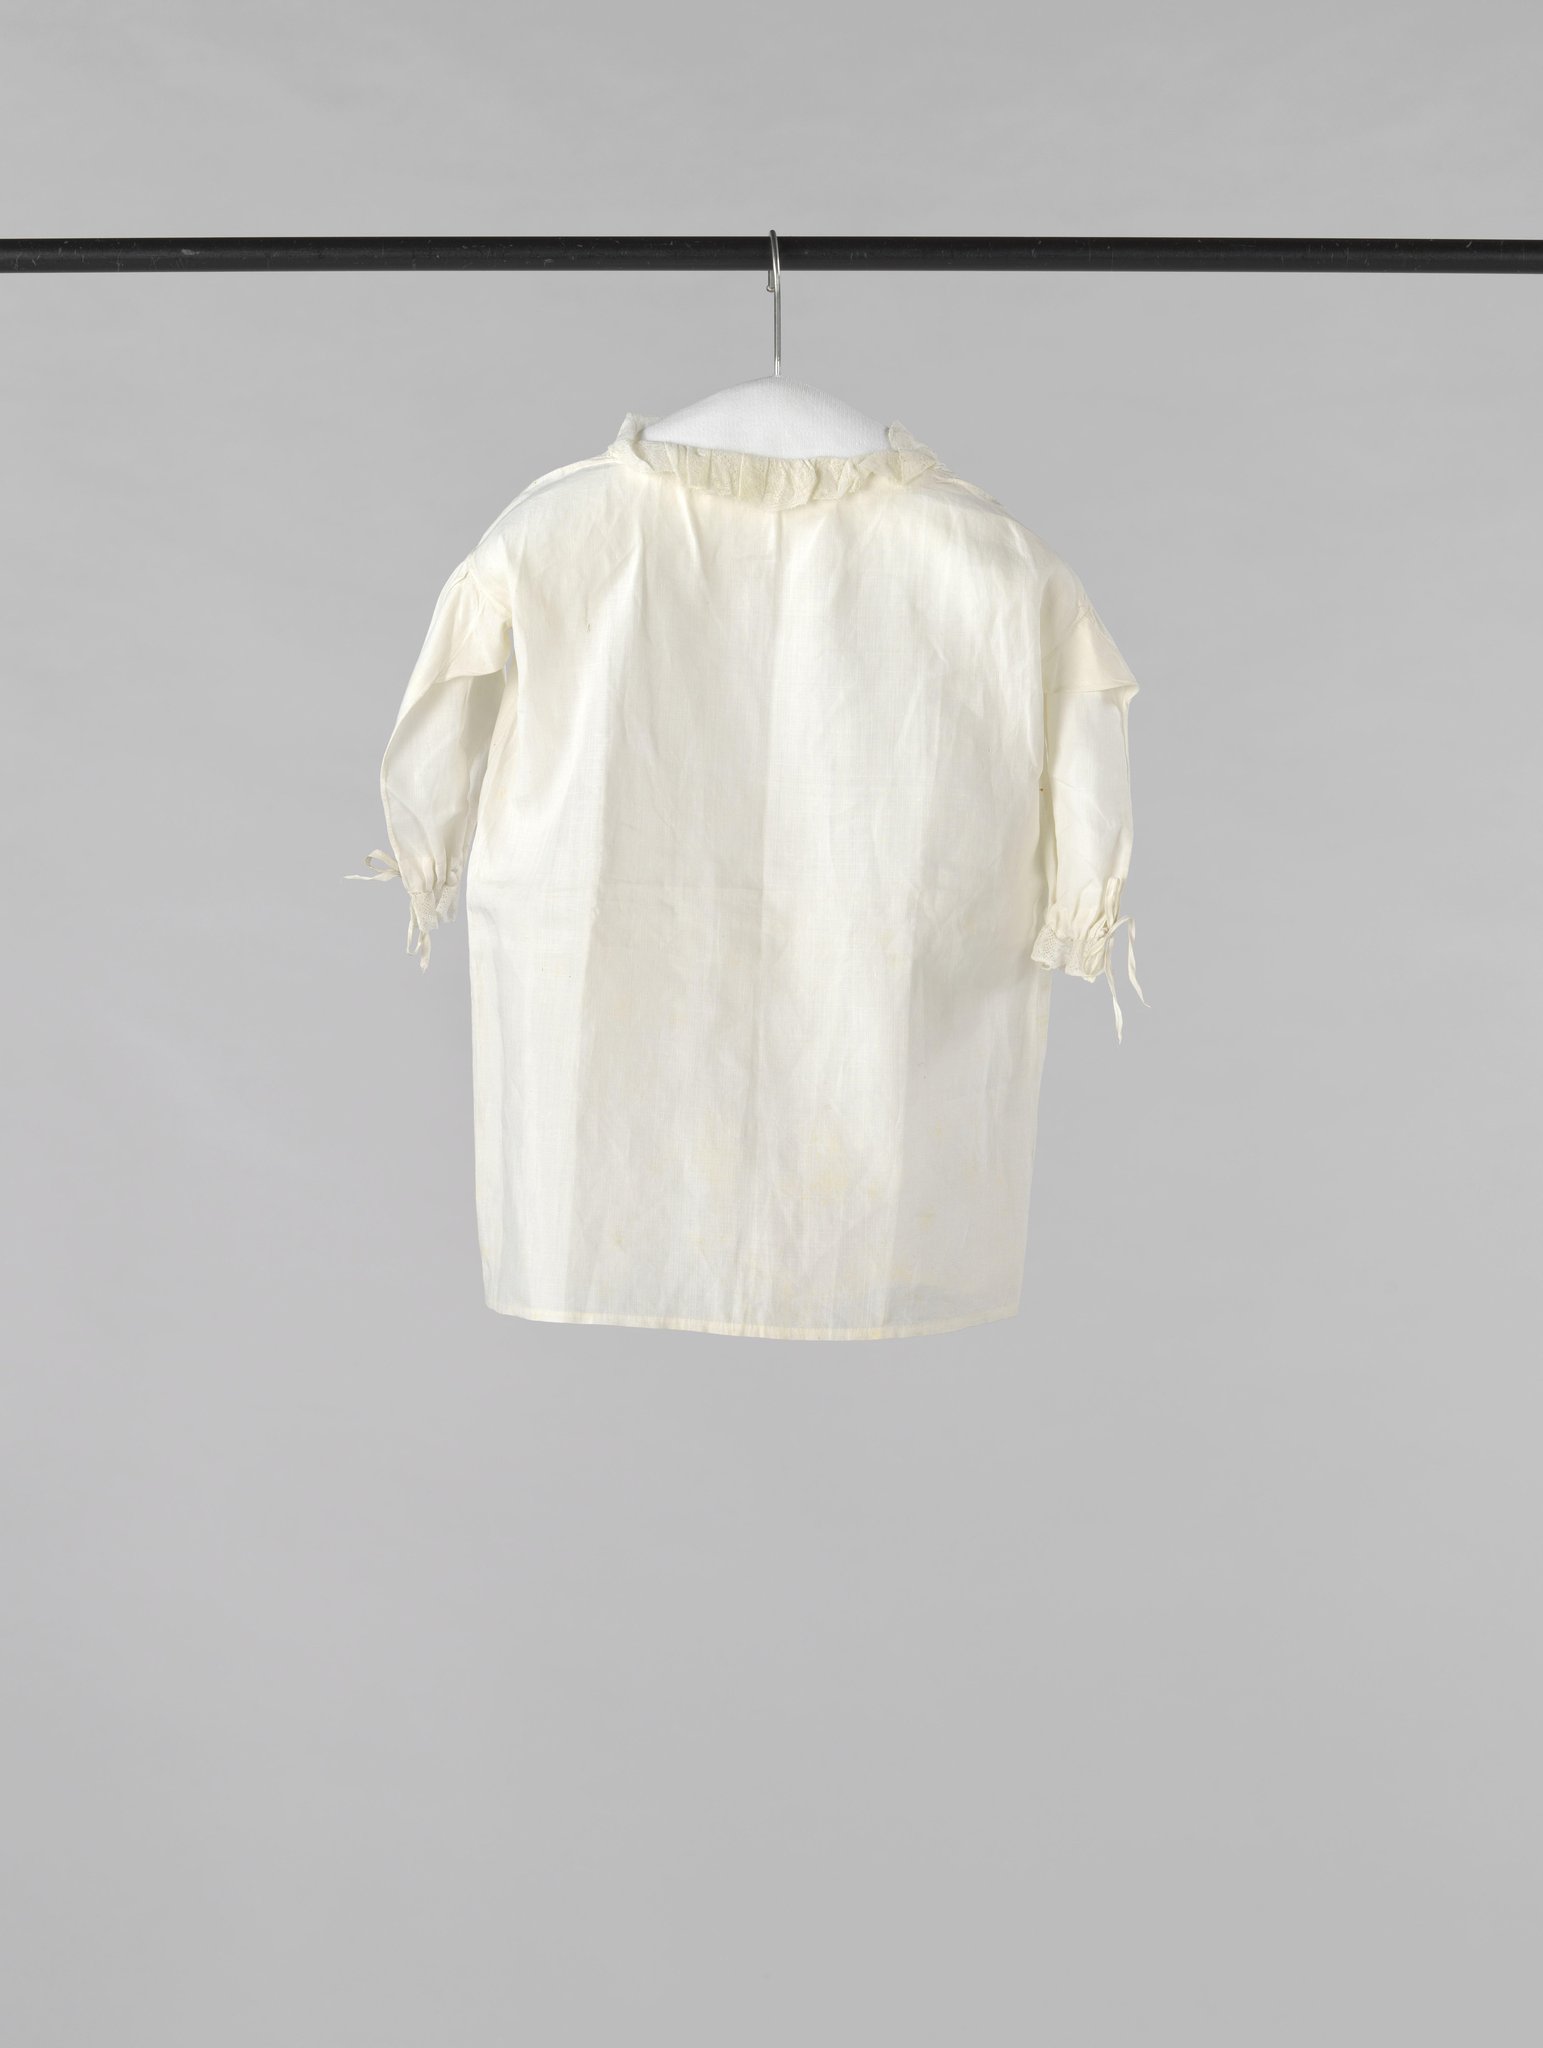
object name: girls' wear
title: Een kinderhemdje, linnen met randjes van Binchekant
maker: Anonymous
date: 1700-1750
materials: linen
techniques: lace